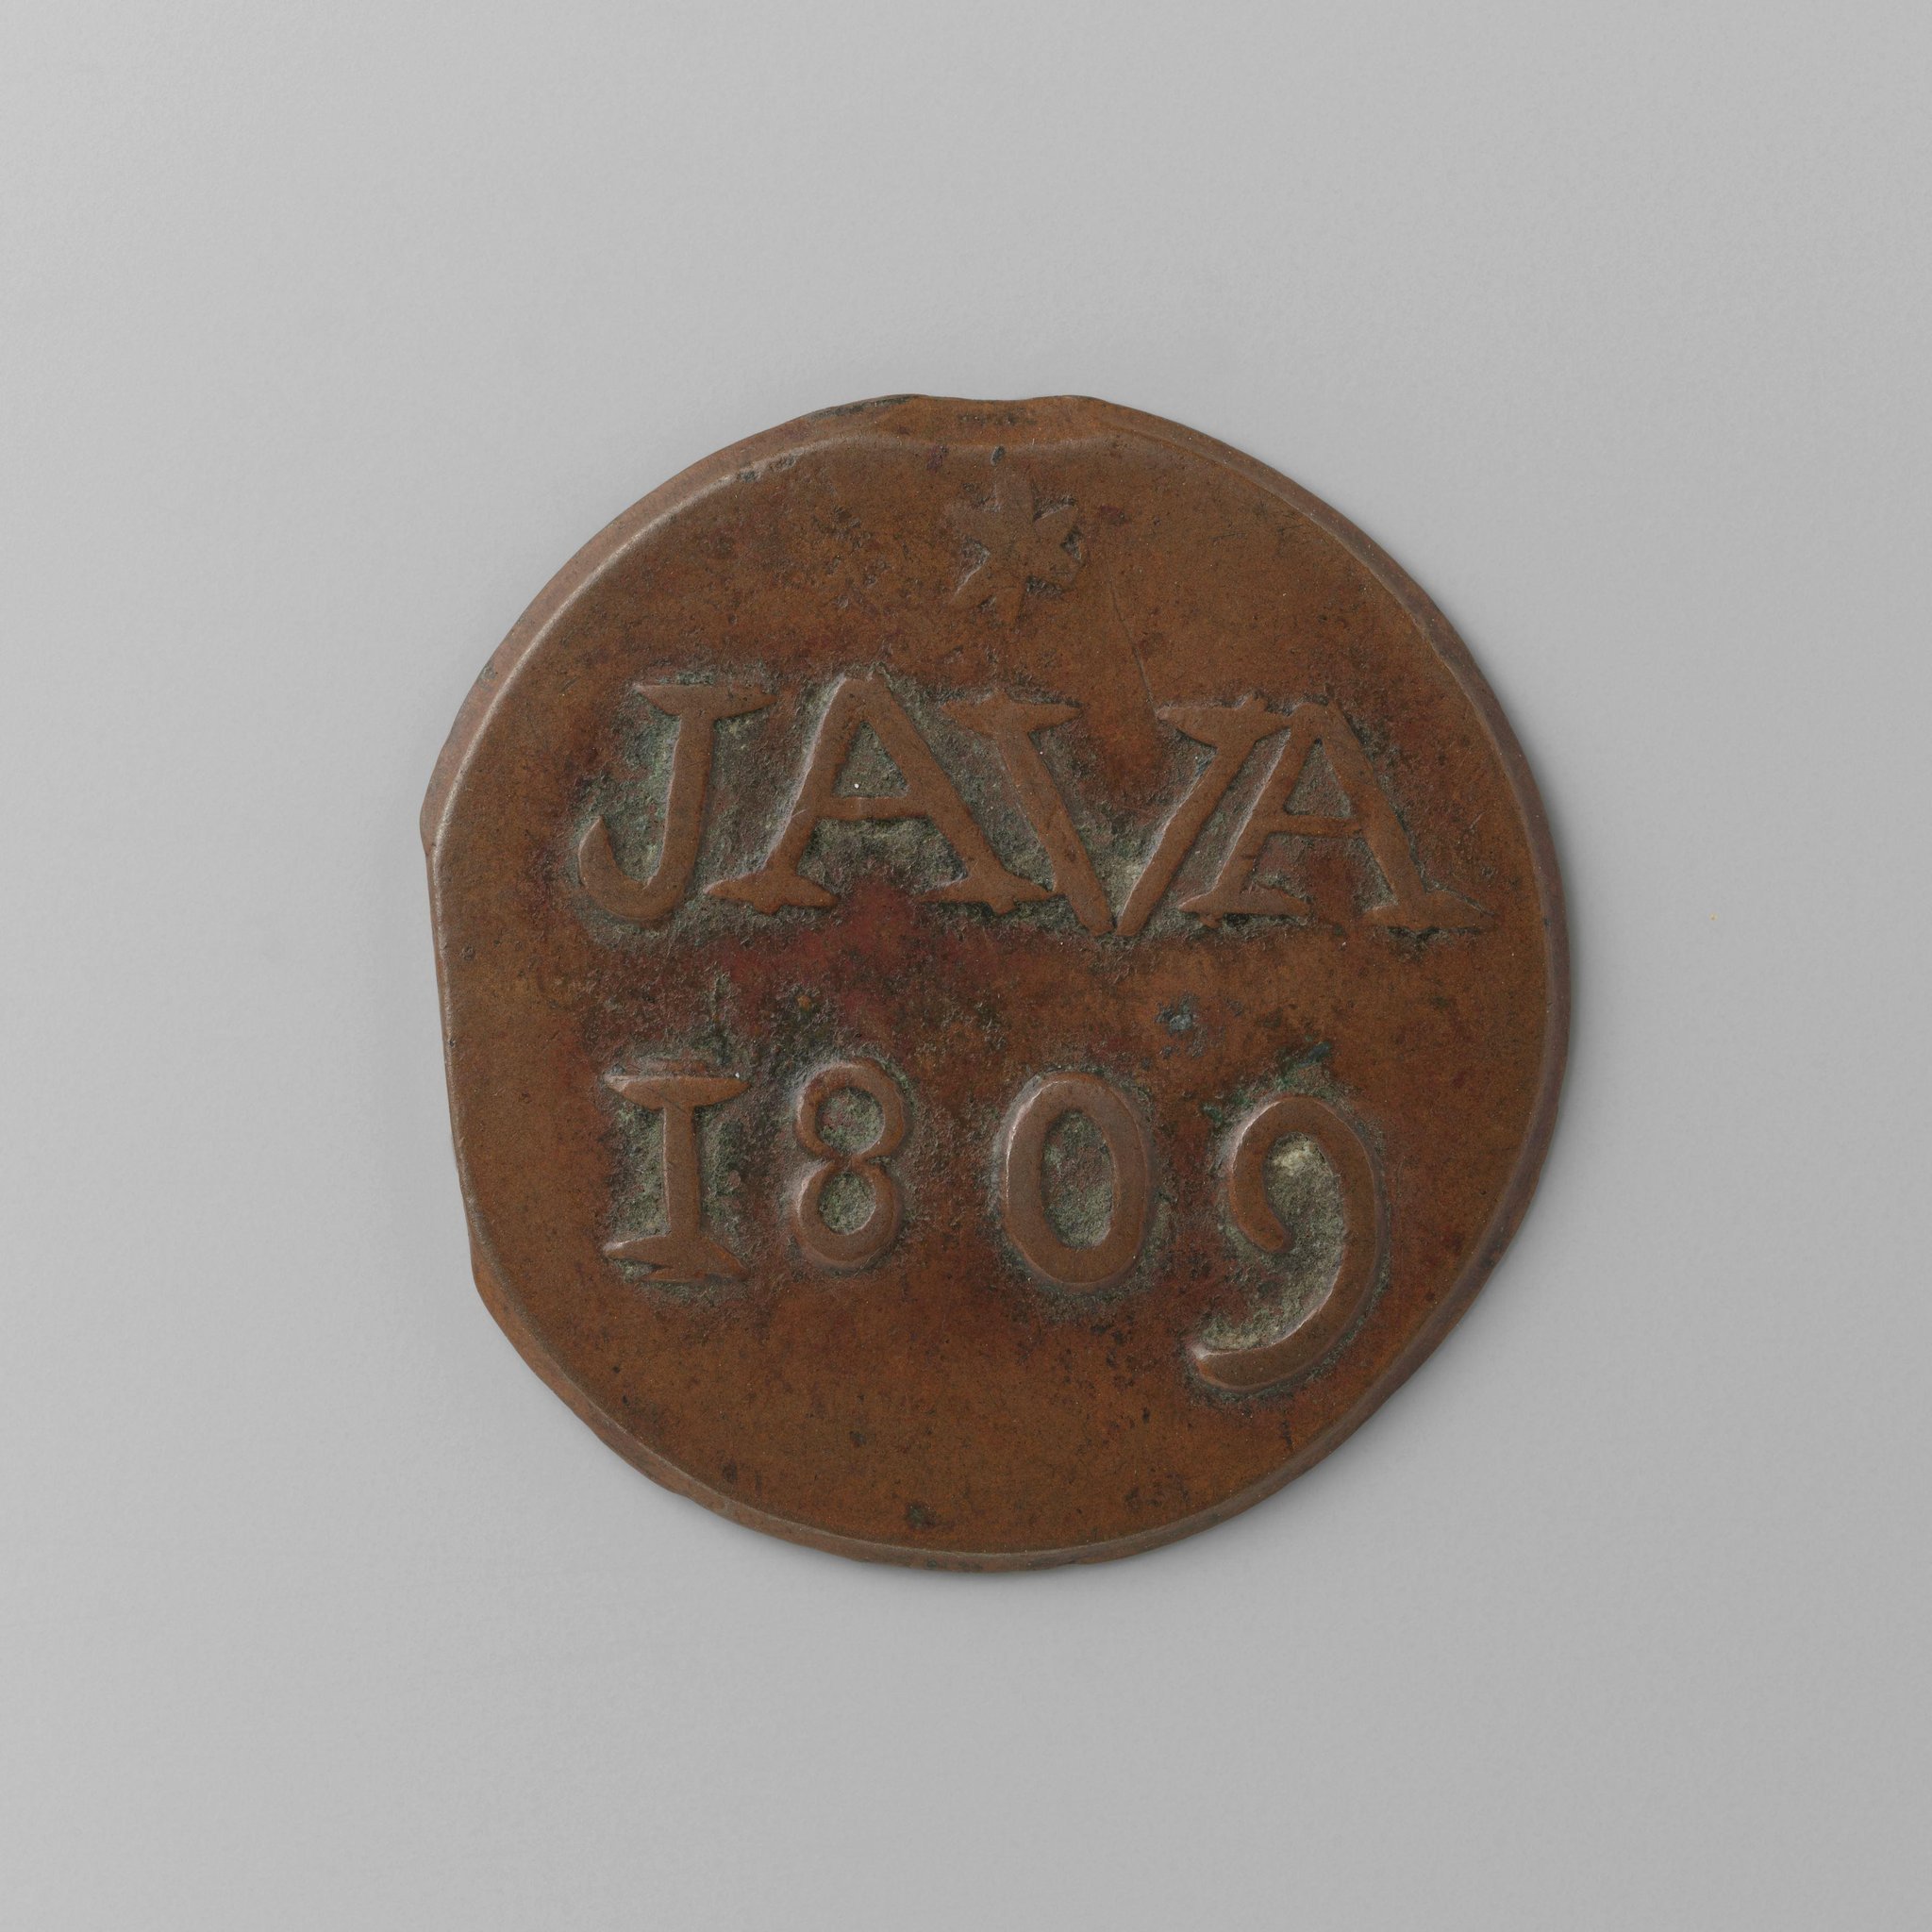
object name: coin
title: Duit voor Nederlands Indië uit Java,1809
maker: louis napoleon (king of holland)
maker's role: koning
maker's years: 1778-1846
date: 1809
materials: copper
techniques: striking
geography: surabaya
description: Koperen munt. Voorzijde: initialen L en N van Lodewijk Napoleon. Daarboven muntteken. Keerzijde: eenregelig opschrift, waaronder jaartal. Boven opschrift muntteken.